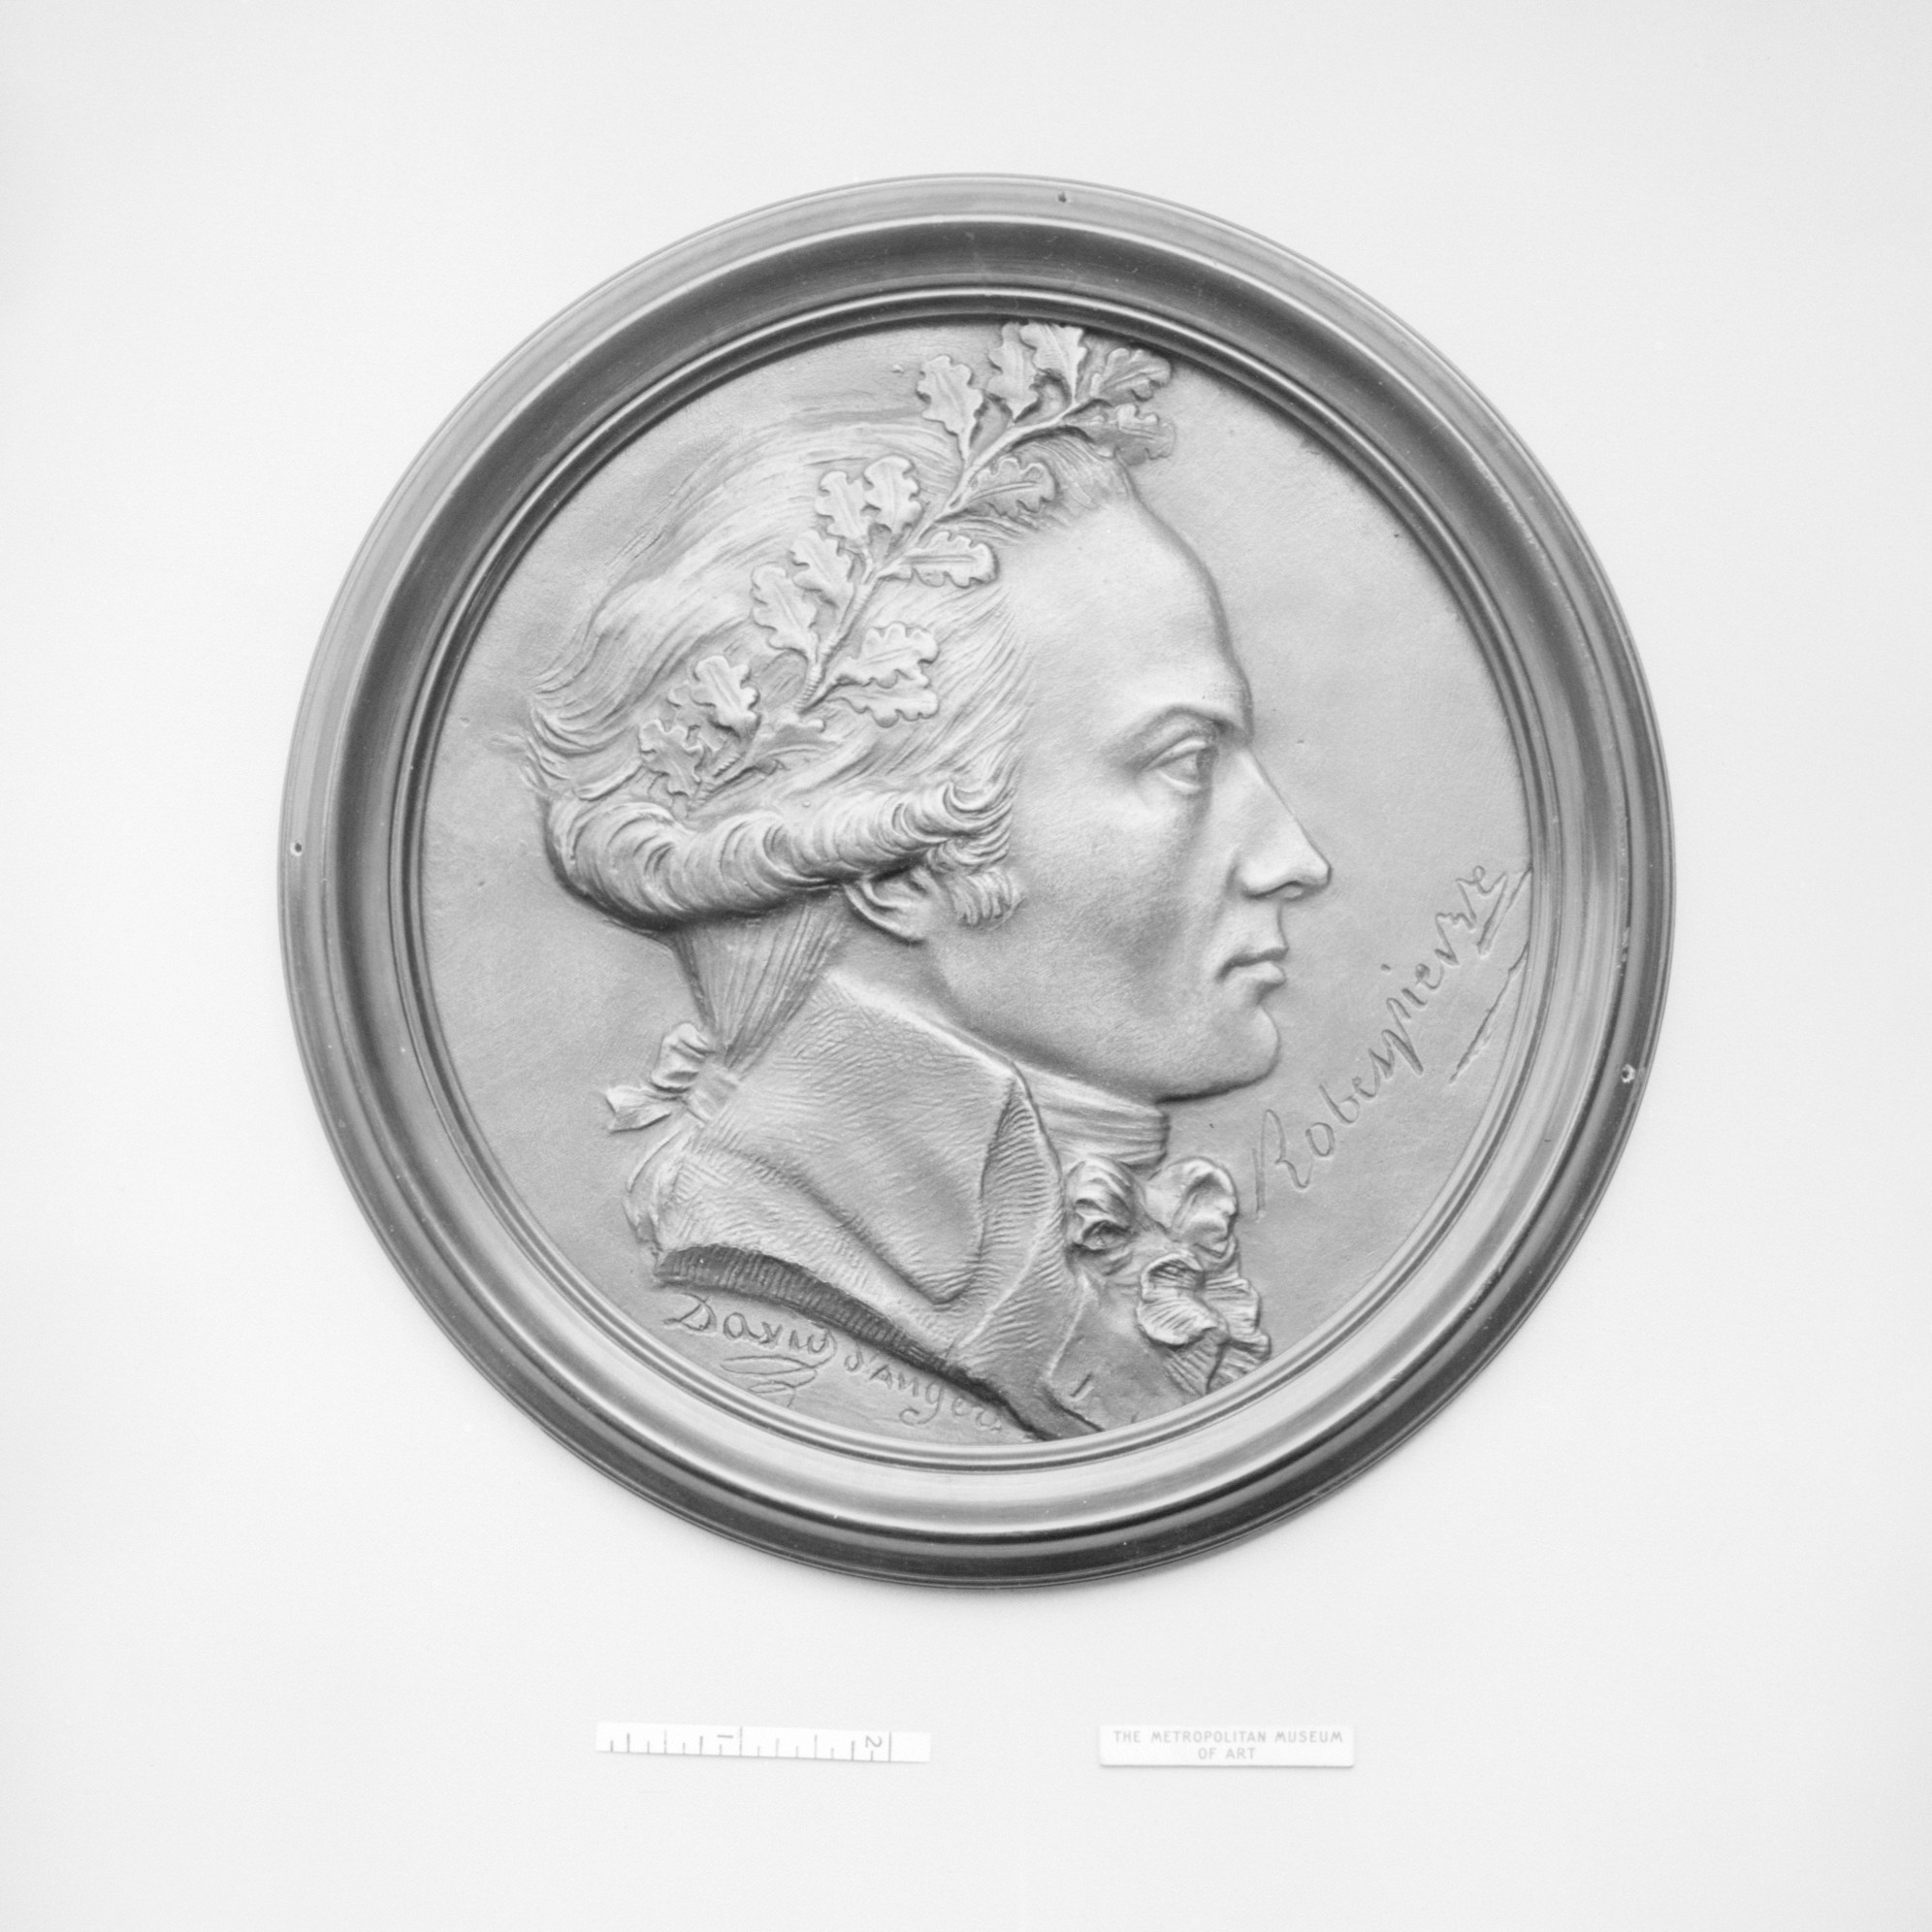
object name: plaque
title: Maximilien Marie Isidore Robespierre (1758–1794), French revolutionary and investigator of "the Terror"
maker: pierre jean david d'angers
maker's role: artist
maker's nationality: french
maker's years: 1788-1856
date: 1801-1900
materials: bronze, patina, wood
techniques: casting, molding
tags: men,profiles